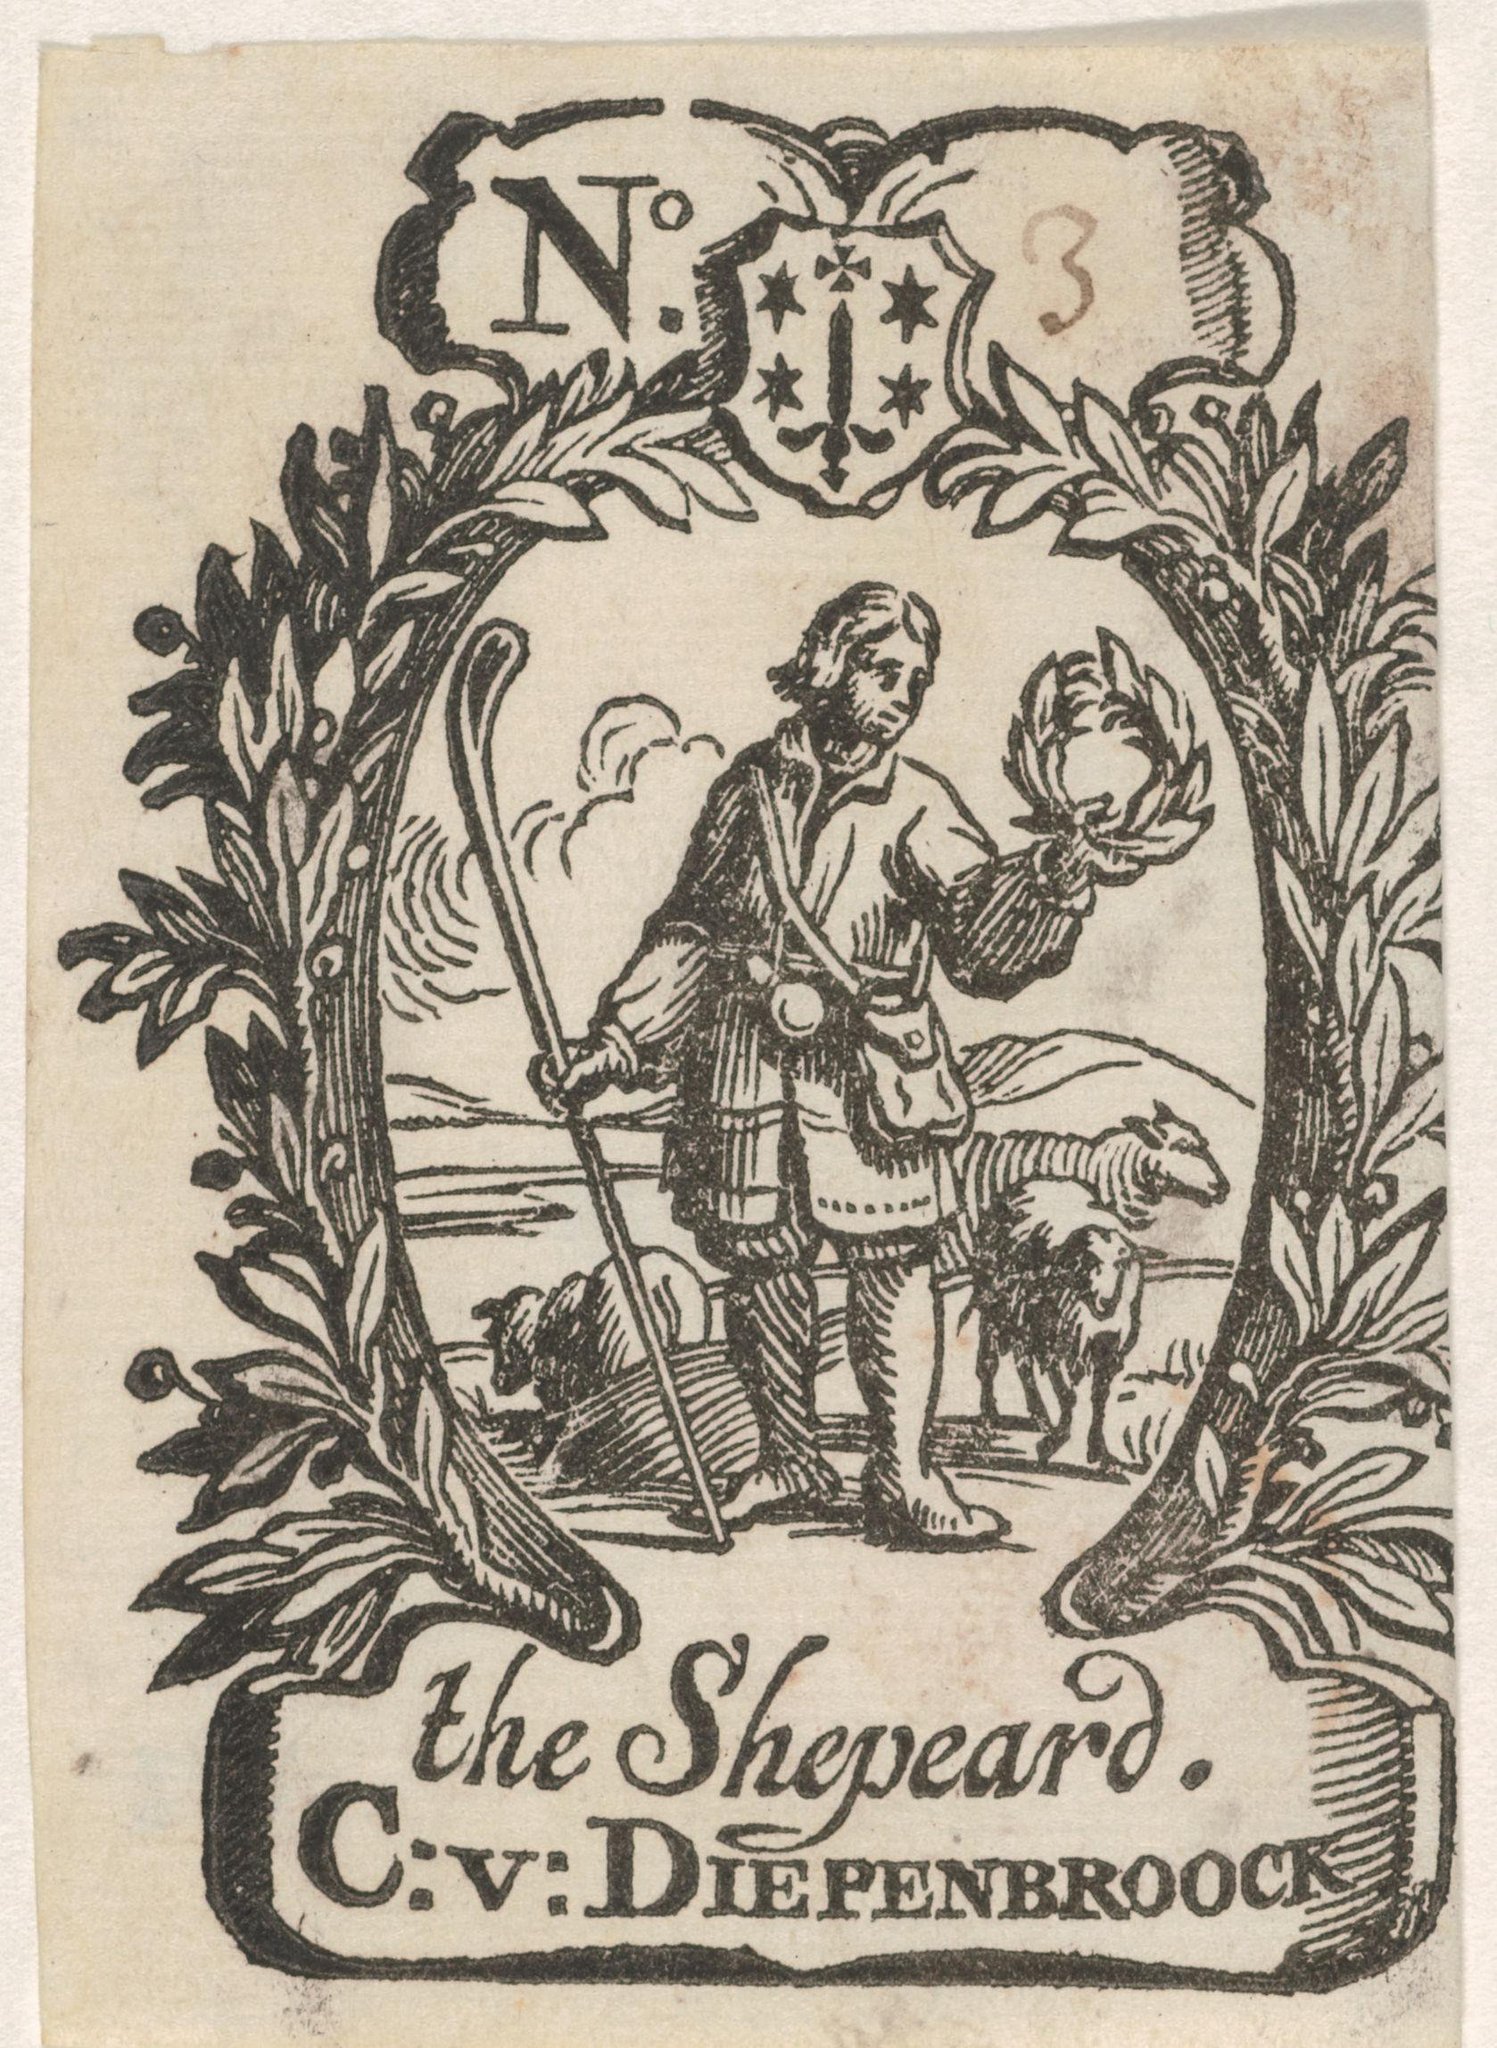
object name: handelsetiket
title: The Shepeard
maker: isaac vincentsz. van der vinne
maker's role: draughtsman, print maker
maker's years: 1665-1740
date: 1681-1740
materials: paper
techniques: woodcut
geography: haarlem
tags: coat of arms (as symbol of the state, etc.) (+ city; municipal), herding, herdsman, herdswoman, shepherd, shepherdess, cowherd, etc., sheep, vignette, haarlem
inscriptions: collector's mark: Lugt 240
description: Een herder met zijn schapen in een ovaal van lauwerbladen. Midden boven het wapen van de stad Haarlem.